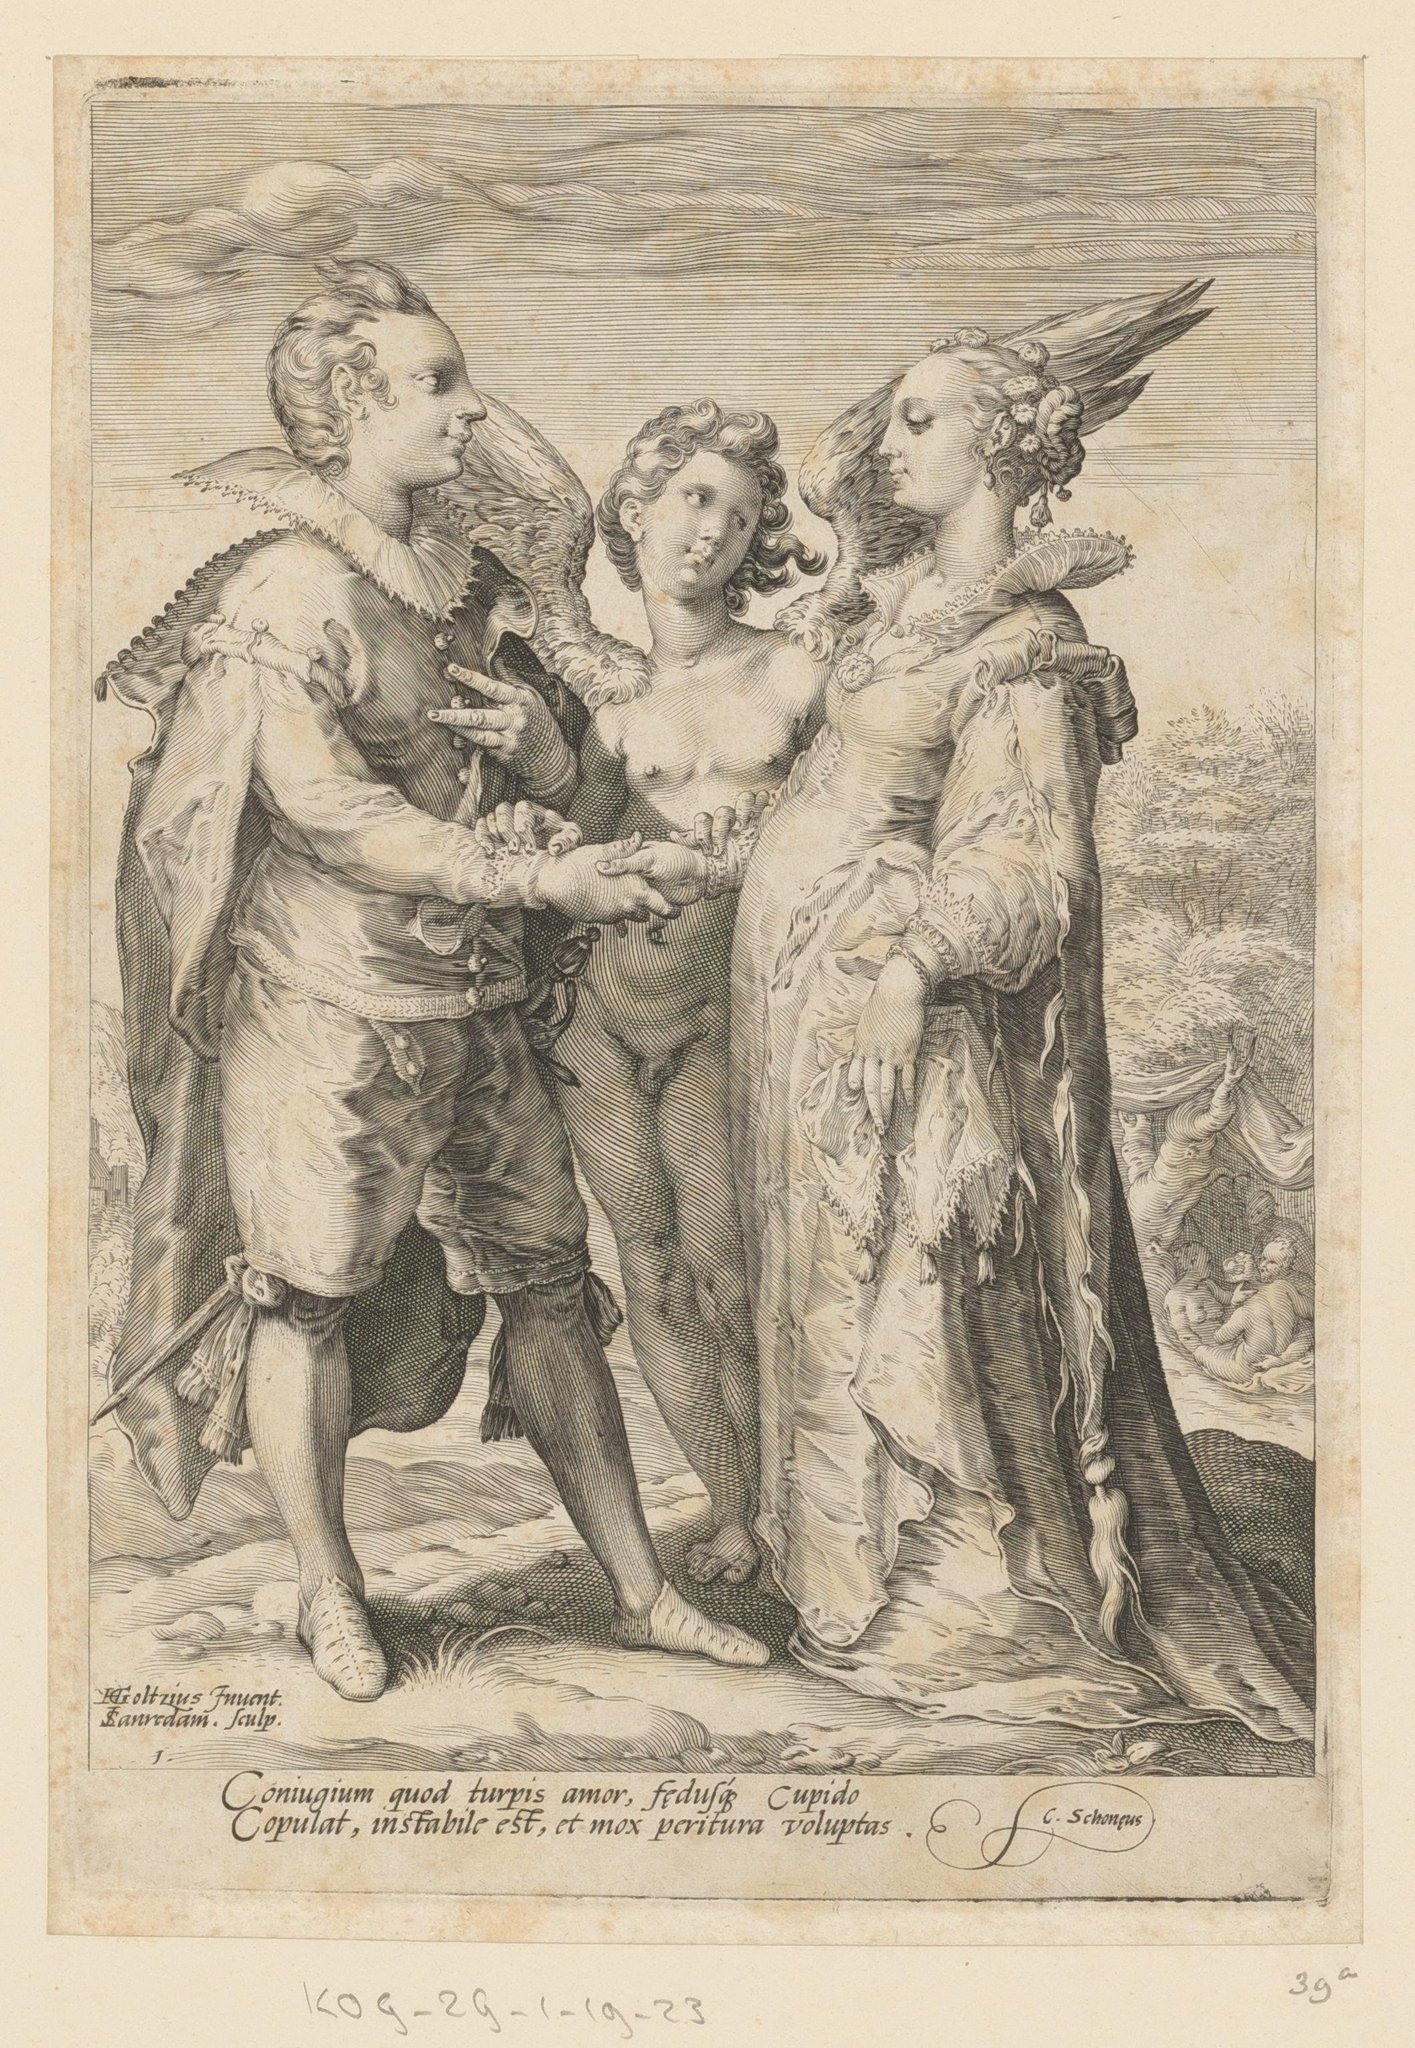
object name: print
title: Verschillende typen huwelijken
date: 1575-1607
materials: paper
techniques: engraving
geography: northern netherlands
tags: (personifications and symbolic representations of) qualities of love, (story of) cupid, amor (eros), (civil) marriage ceremonies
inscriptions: collector's mark:, collector's mark: Lugt 963, collector's mark: Lugt 1641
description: Amor verbindt een man en vrouw, die als paar de wereldse liefde symboliseren, in de echt. In de marge een onderschrift van twee regels in het Latijn. Onderwerpsrubrieken binnen de Atlas Zeden en Gewoonten: Des Menschen Begin, Midden en Einde. Bruiloft en huwelijk.